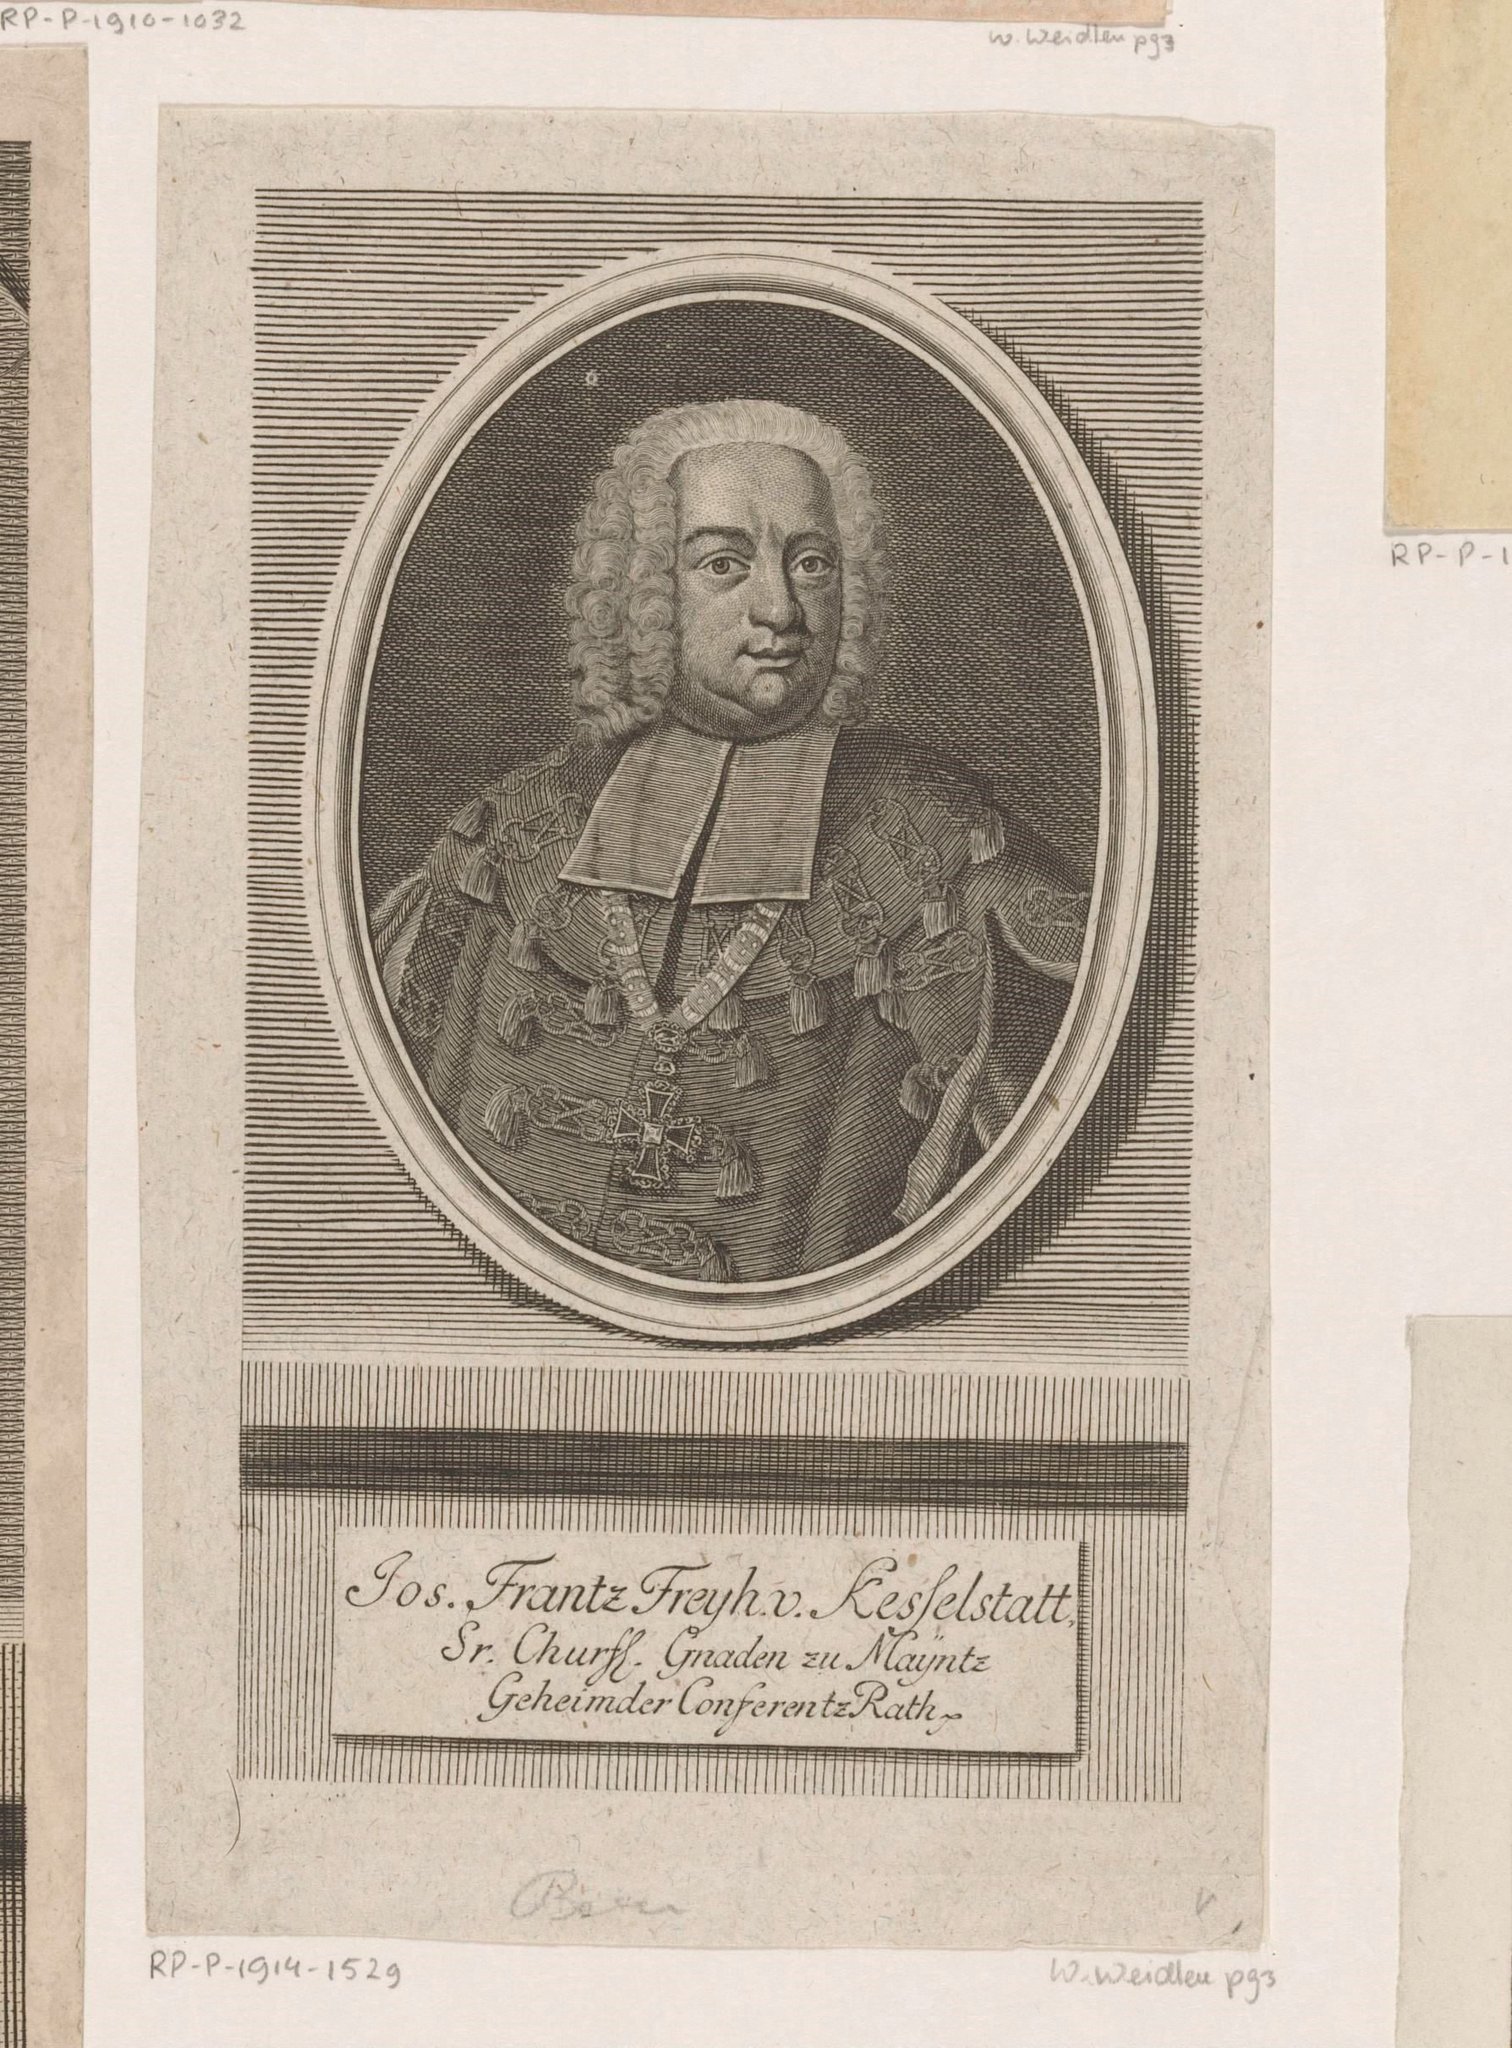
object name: print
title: Portret van Johann Franz von Kesselstatt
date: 1743-1767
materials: paper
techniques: engraving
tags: historical persons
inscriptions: collector's mark: Lugt 2228